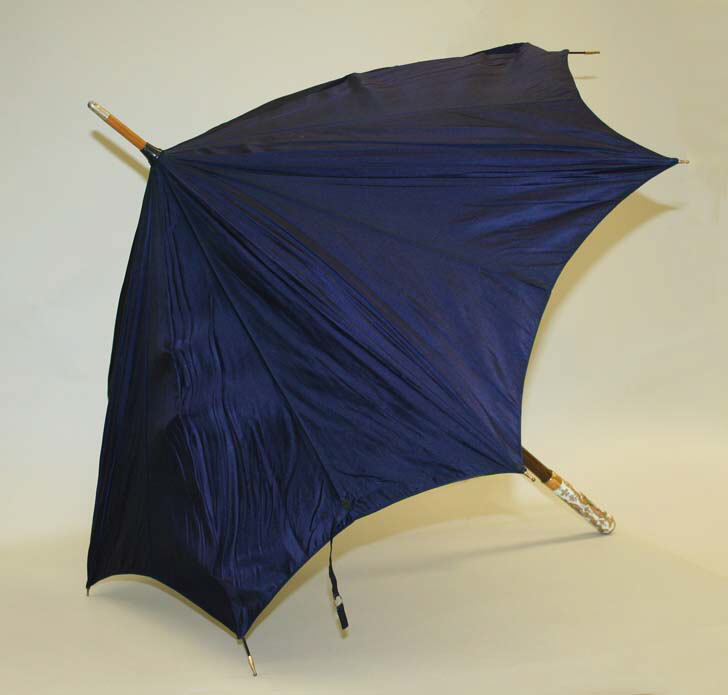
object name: parasol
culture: american or european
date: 1890-1899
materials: metal, silk, wood